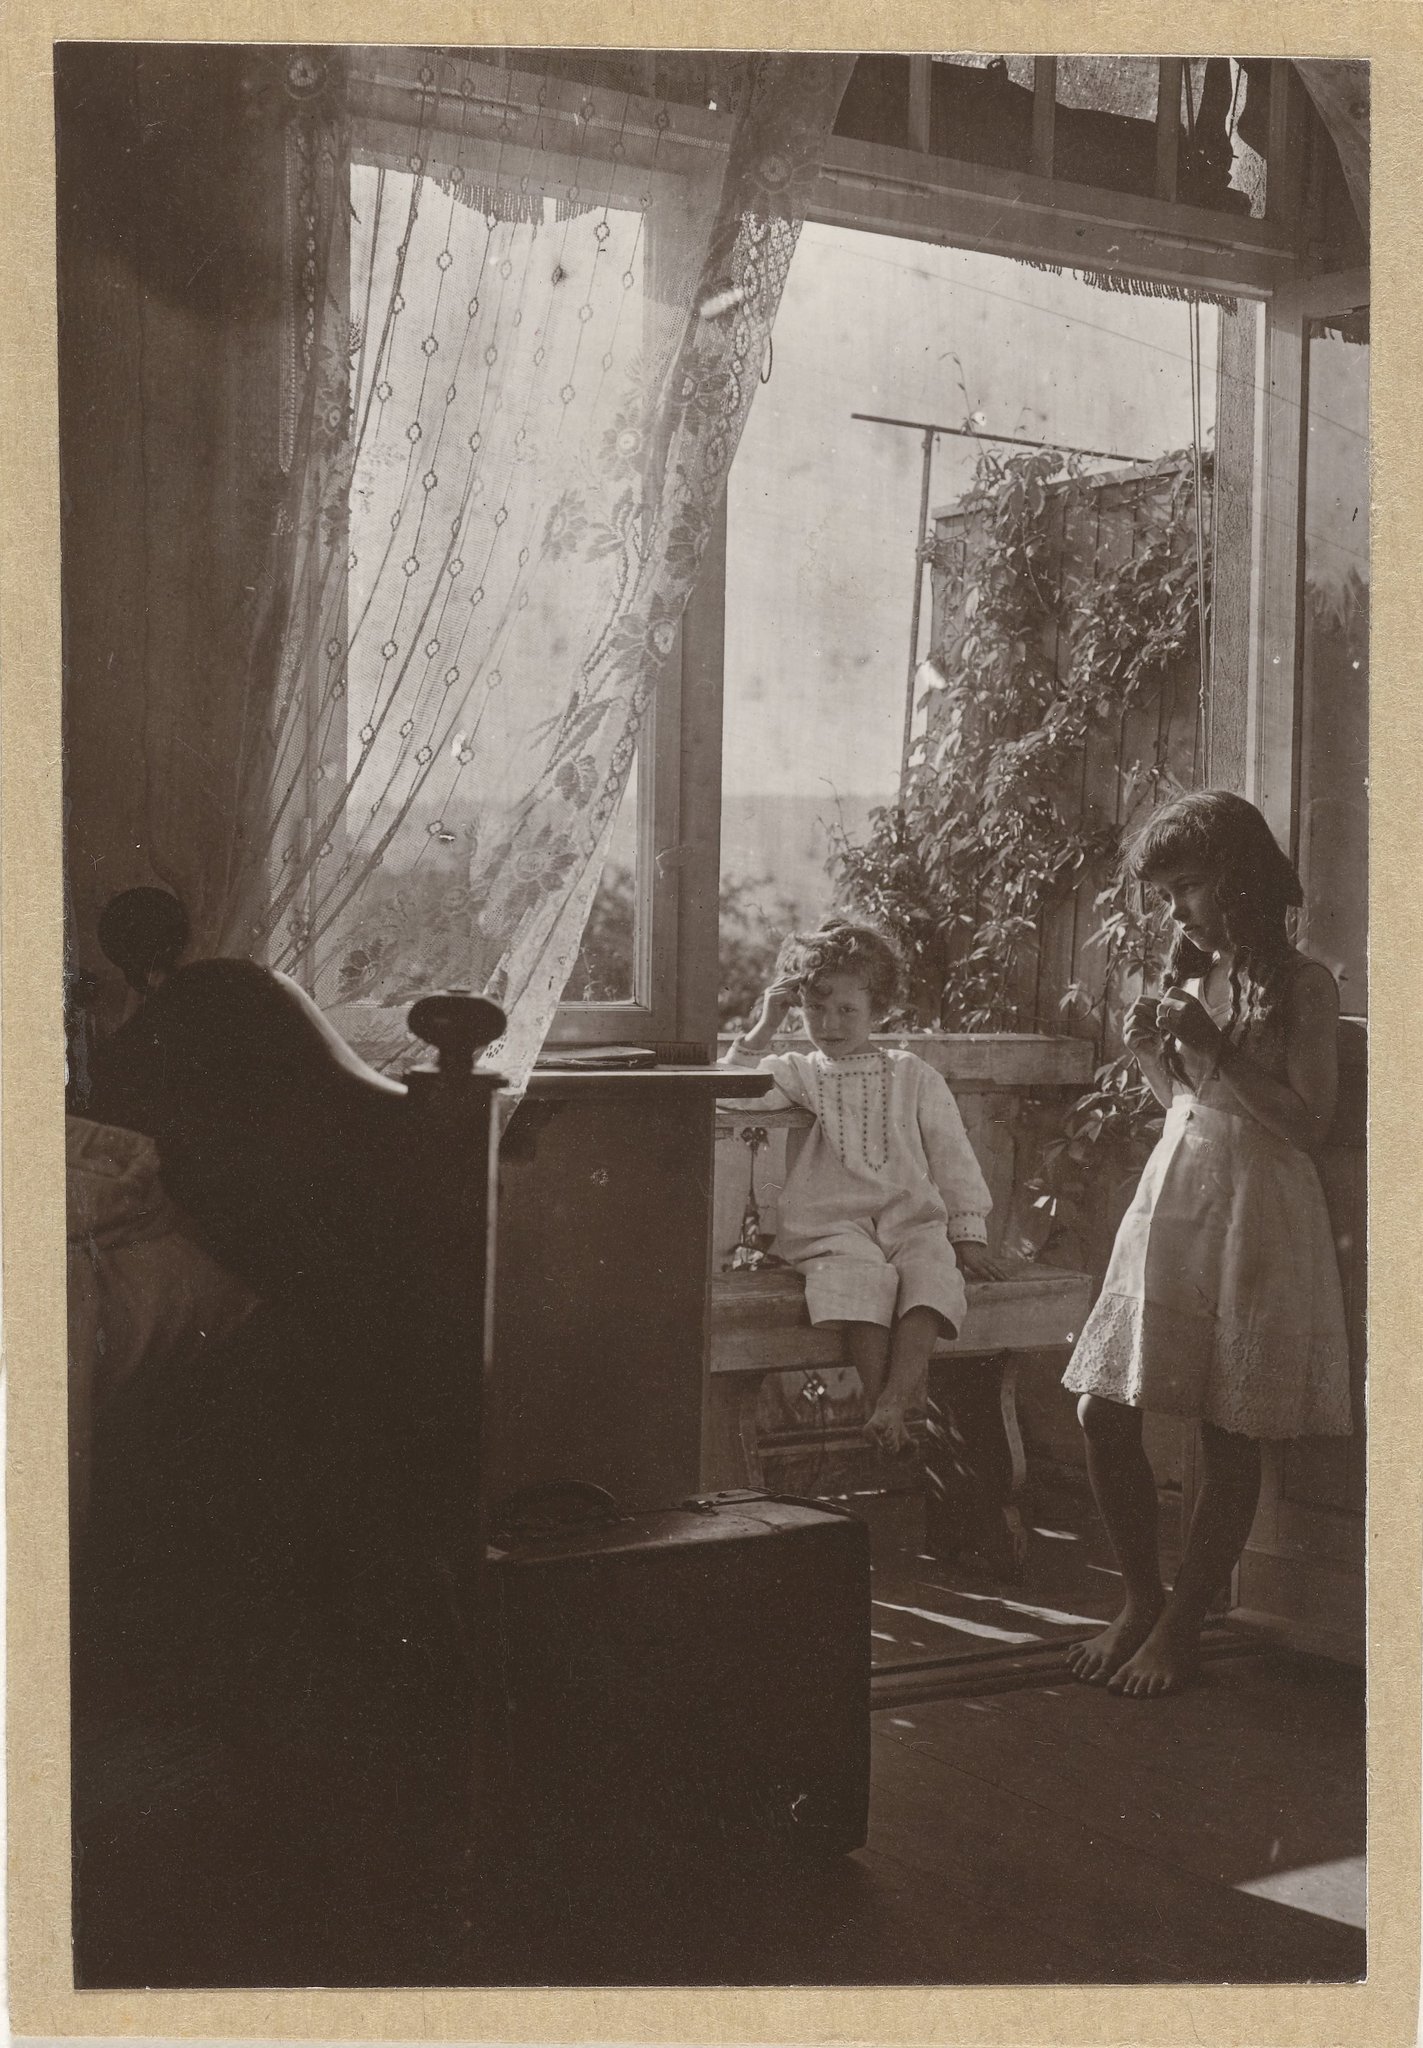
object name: photograph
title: Marba en Eckart Titzenthaler, kinderen van de fotograaf, op een balkon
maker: waldemar titzenthaler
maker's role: fotograaf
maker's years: 1869-1937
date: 1918-1919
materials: paper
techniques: gelatin silver print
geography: germany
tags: boy (child between toddler and youth), girl (child between toddler and youth), germany